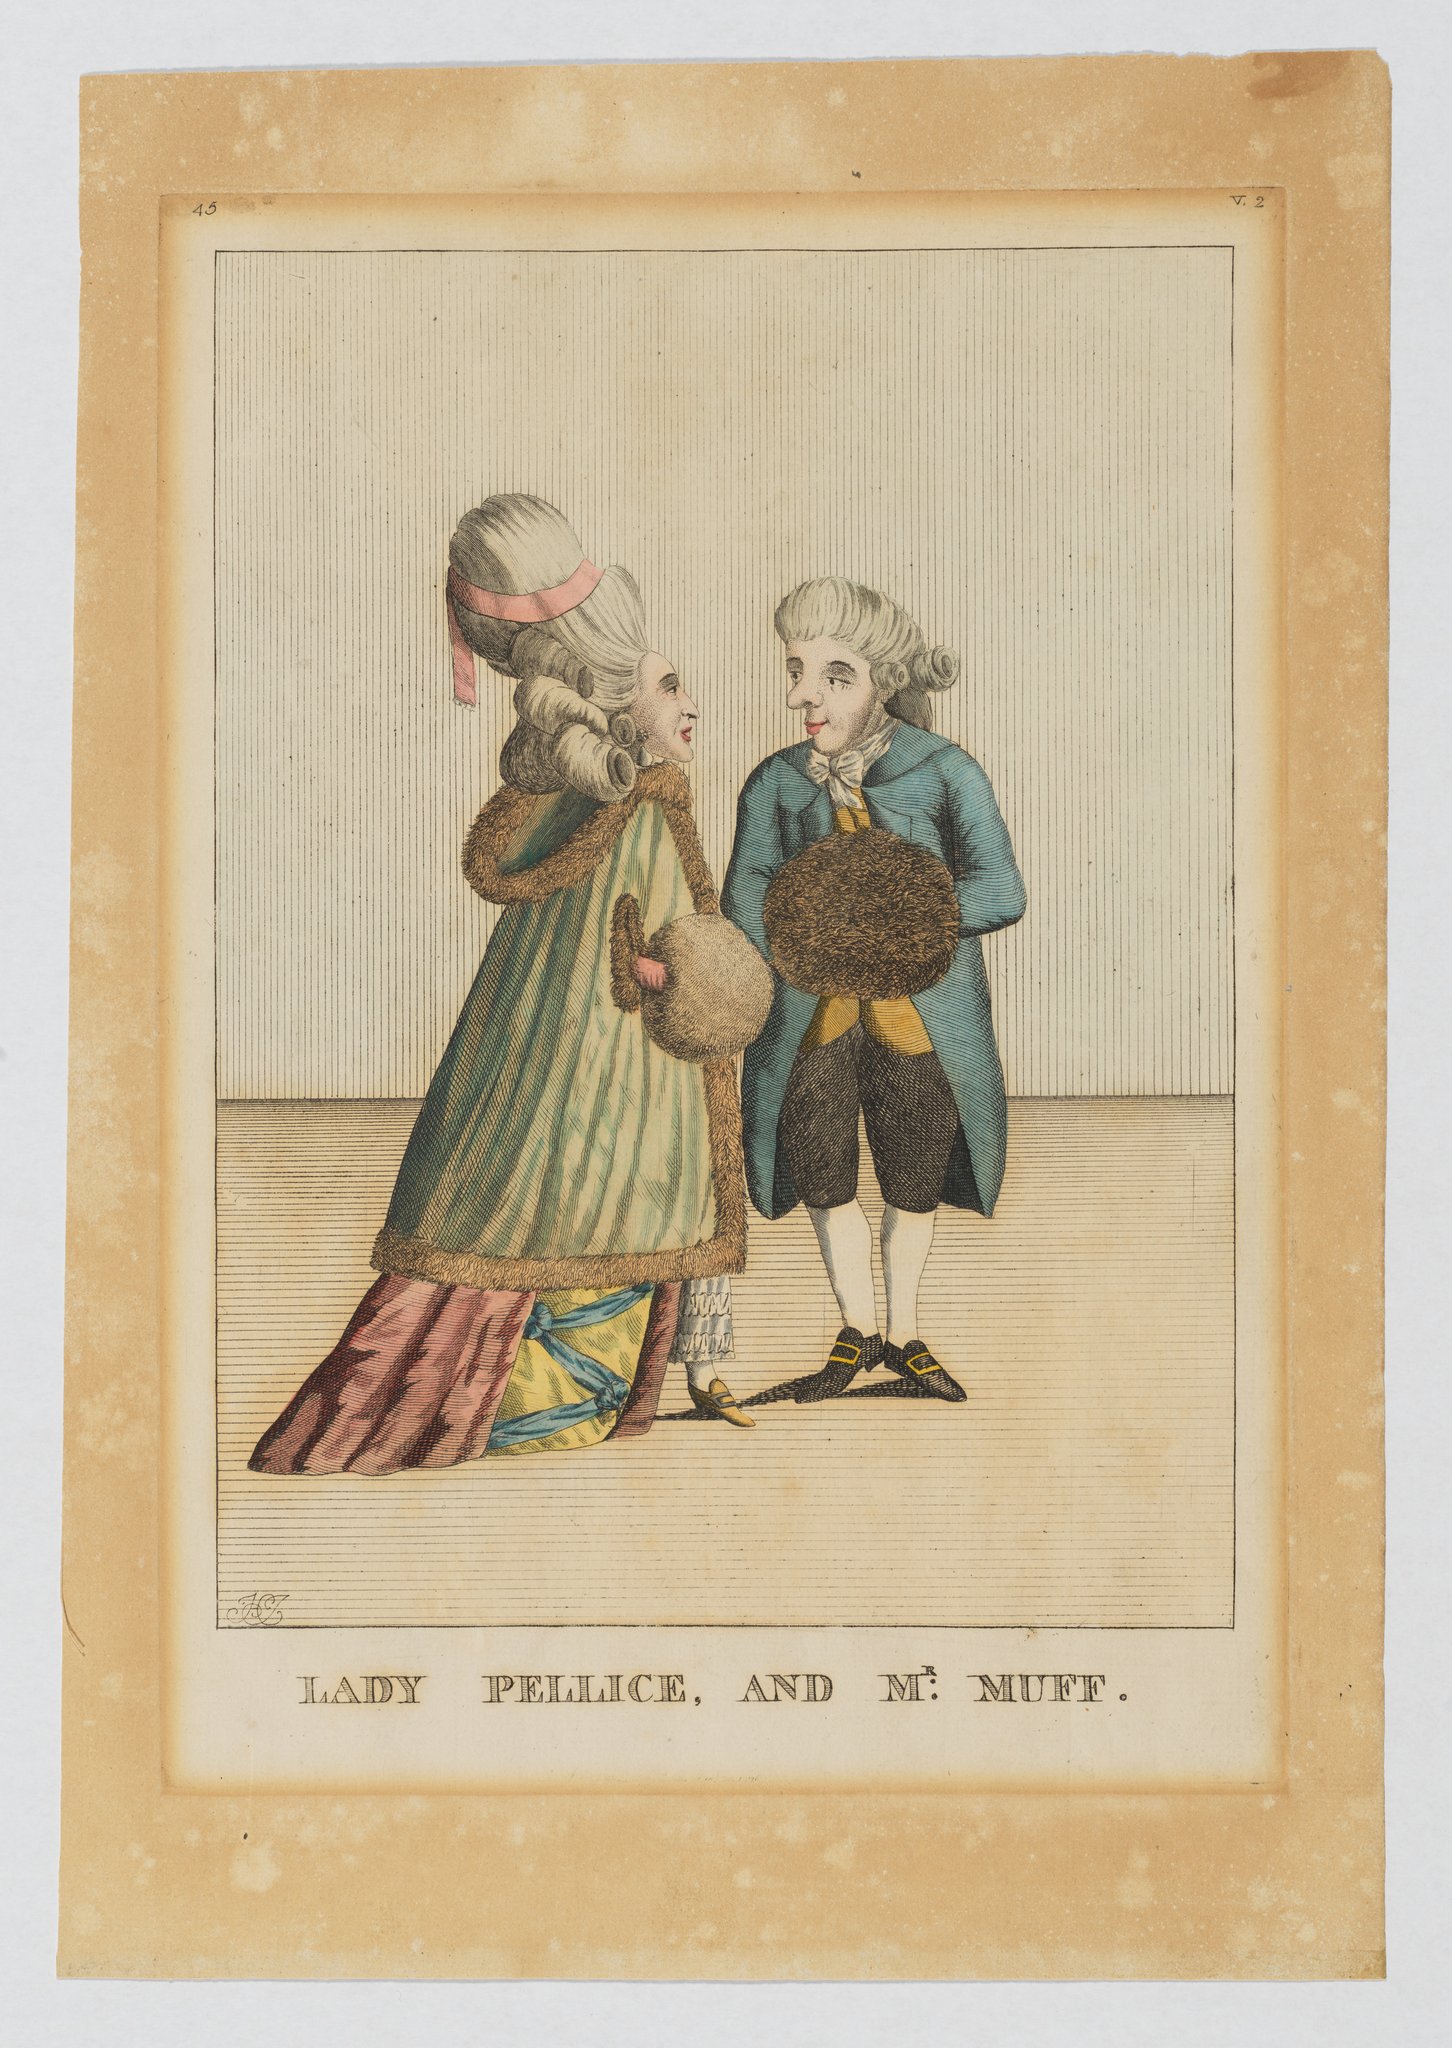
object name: print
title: Lady Pellice and Mr. Muff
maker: h. j.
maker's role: artist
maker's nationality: british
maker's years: 1778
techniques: engraving, etching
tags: satire,men,women